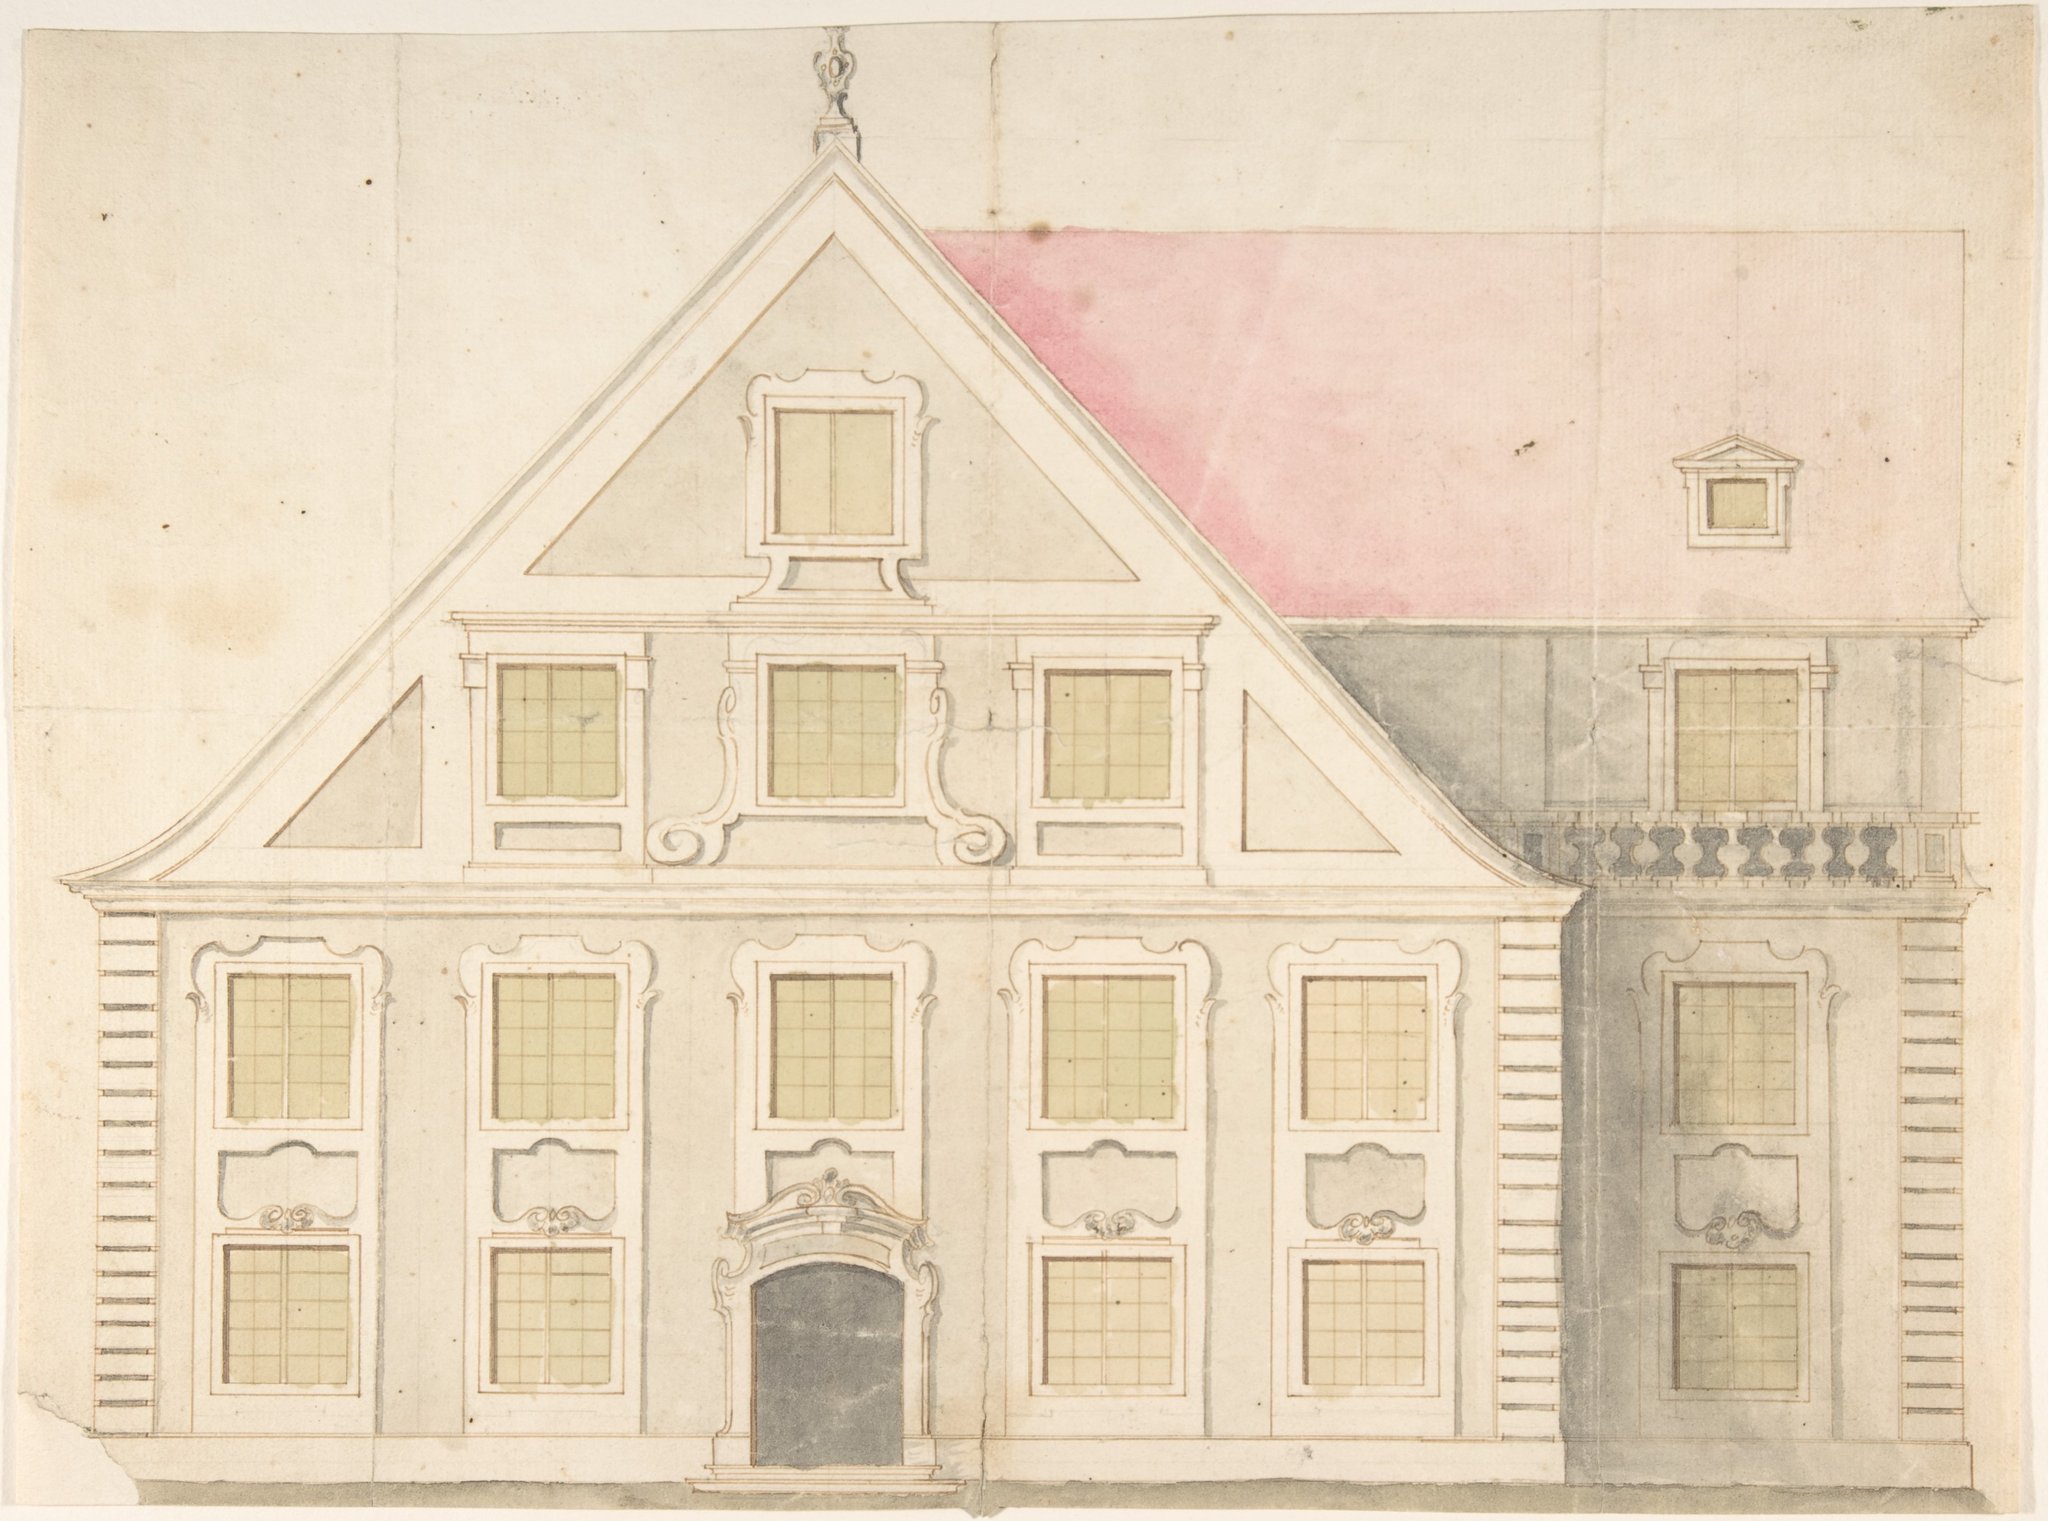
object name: drawing ornament architecture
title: Design for a House Façade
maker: anonymous, german, 18th century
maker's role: artist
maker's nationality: german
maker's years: 1700-1800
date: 1701-1800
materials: ink, watercolor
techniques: brush, cutting, pen, wash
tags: architecture,houses